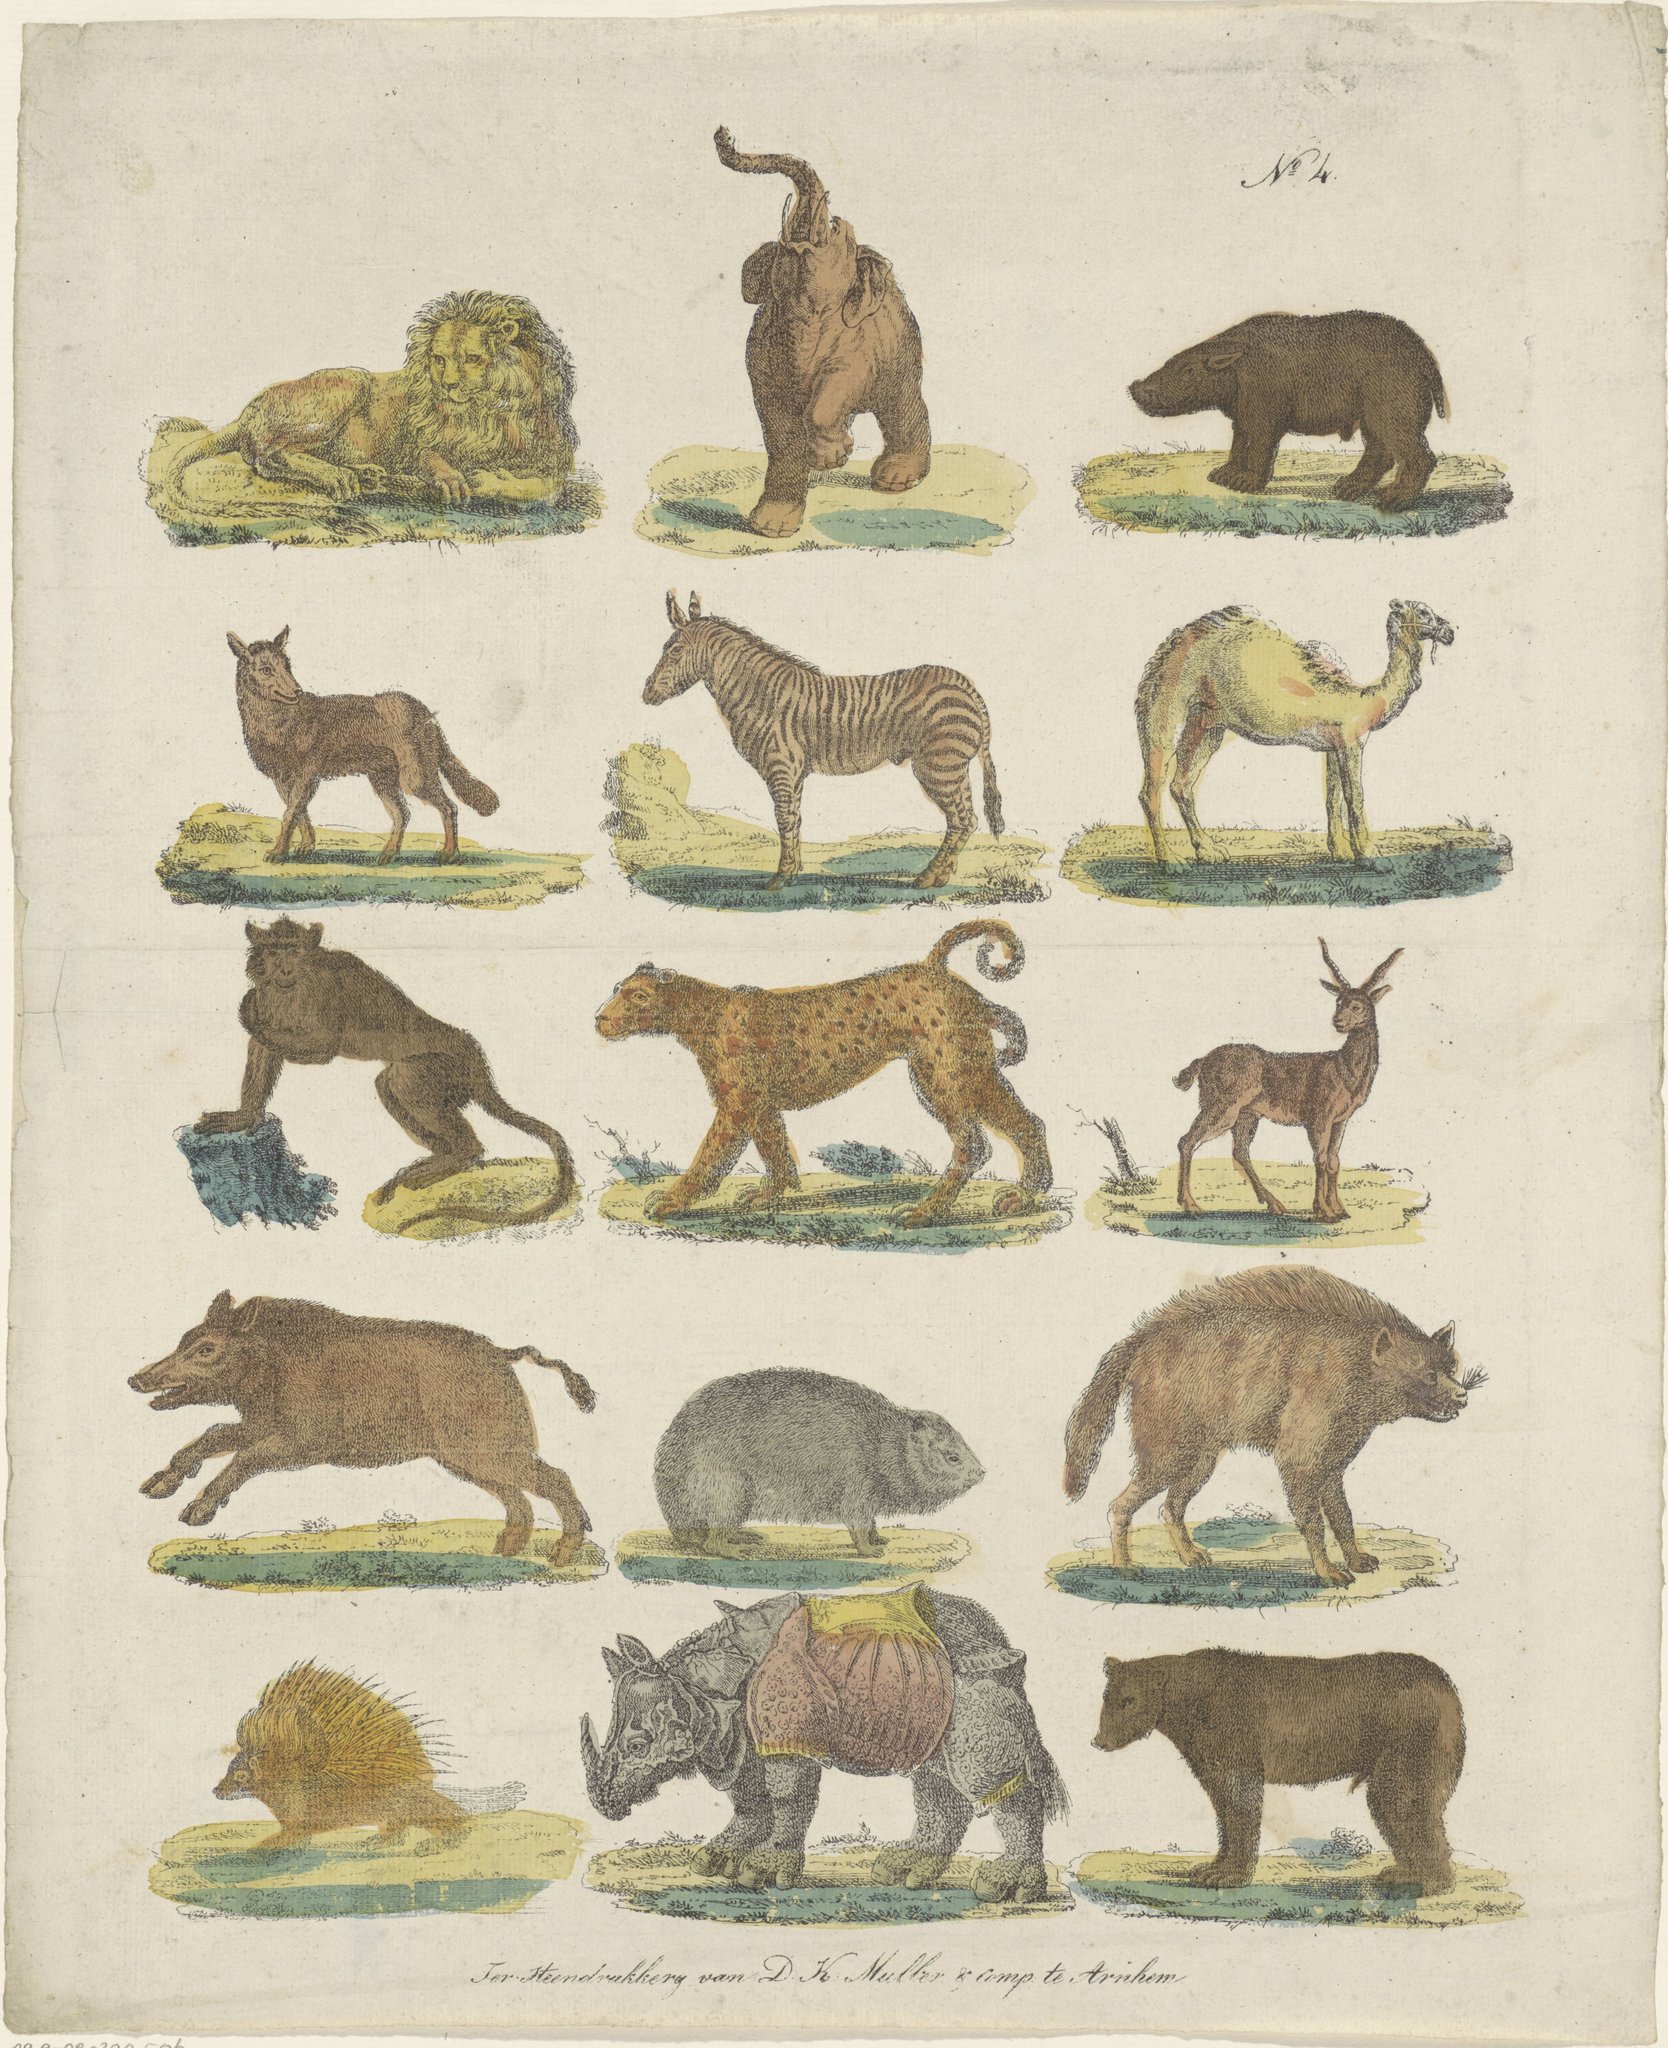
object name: popular print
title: Dieren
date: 1815-1842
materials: paper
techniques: lithograph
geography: netherlands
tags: animals, hoofed animals: rhinoceros, beasts of prey, predatory animals: lion, trunked animals: elephant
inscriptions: collector's mark: Lugt 2760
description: Blad met 15 voorstellingen van dieren, waaronder een leeuw, een olifant een zebra en een neushoorn. Genummerd rechtsboven: No. 4.